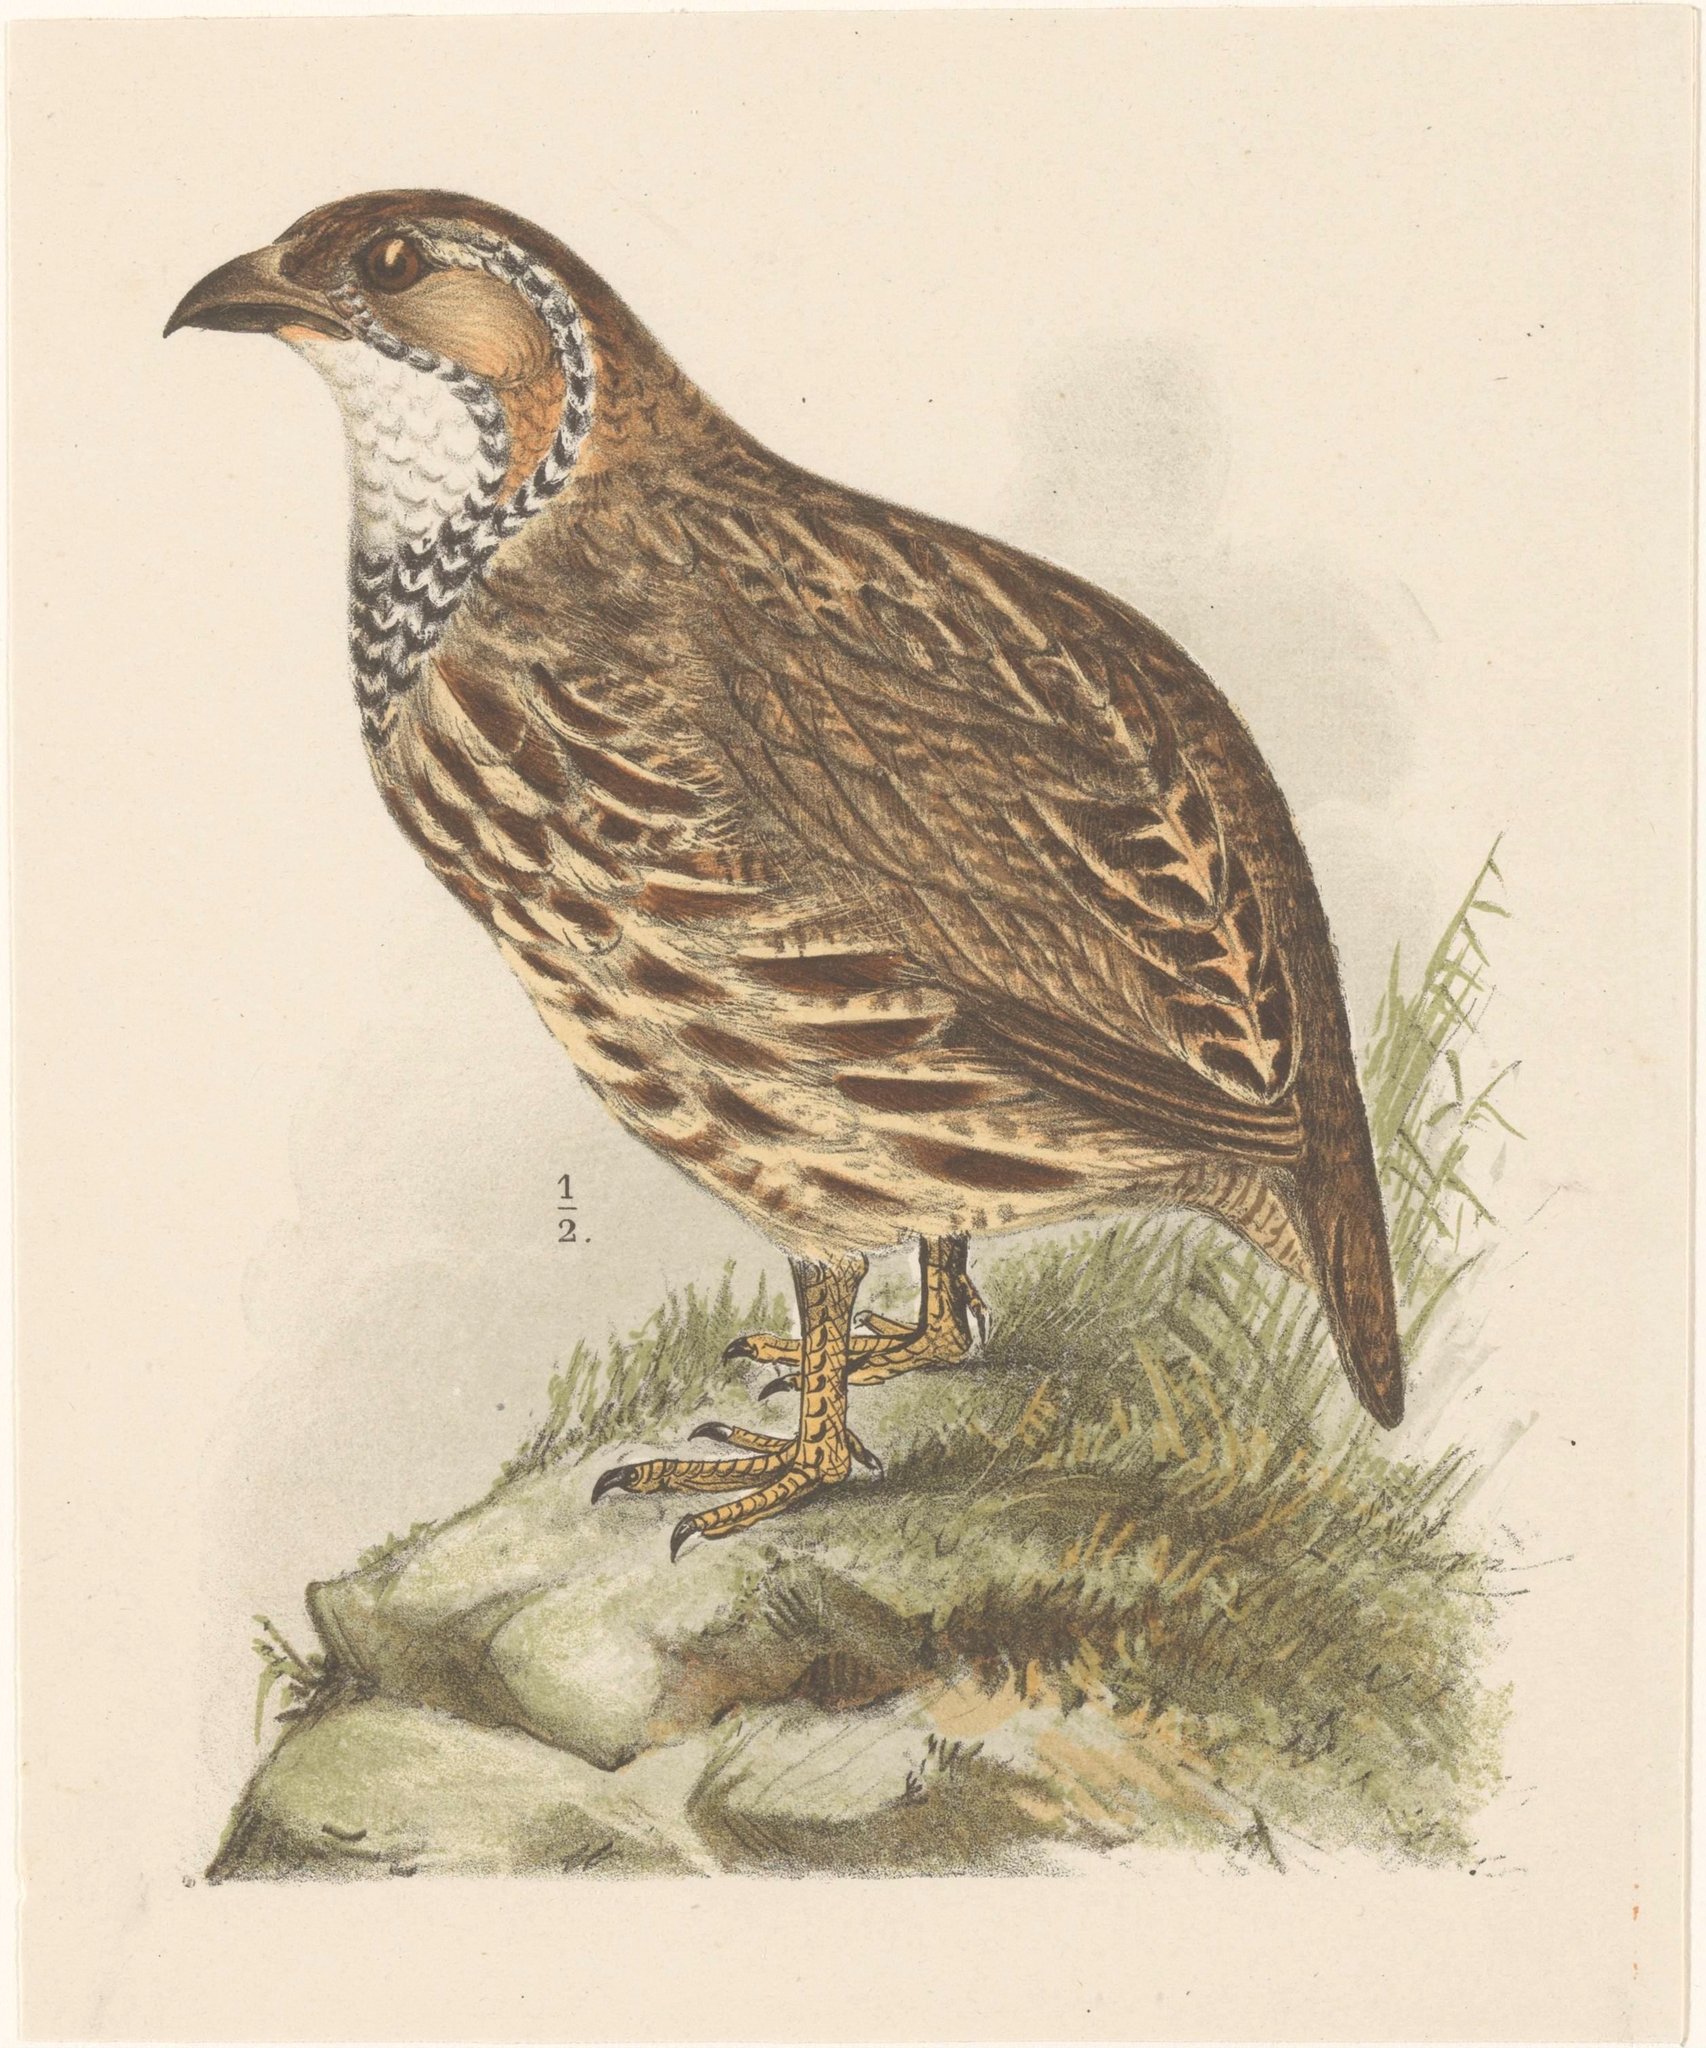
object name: print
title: Patrijs (francolinus jugularis)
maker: theo van hoytema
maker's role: draughtsman, painter, print maker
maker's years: 1863-1917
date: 1878-1889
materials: paper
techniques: lithograph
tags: walker and runner birds: partridge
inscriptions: collector's mark: Lugt 2228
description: Prent ook gebruikt voor: J. Büttikofer, 'On a new Collection of Birds from South Western Africa', Notes from the Leyden Museum XI (1889), p. 65-79.